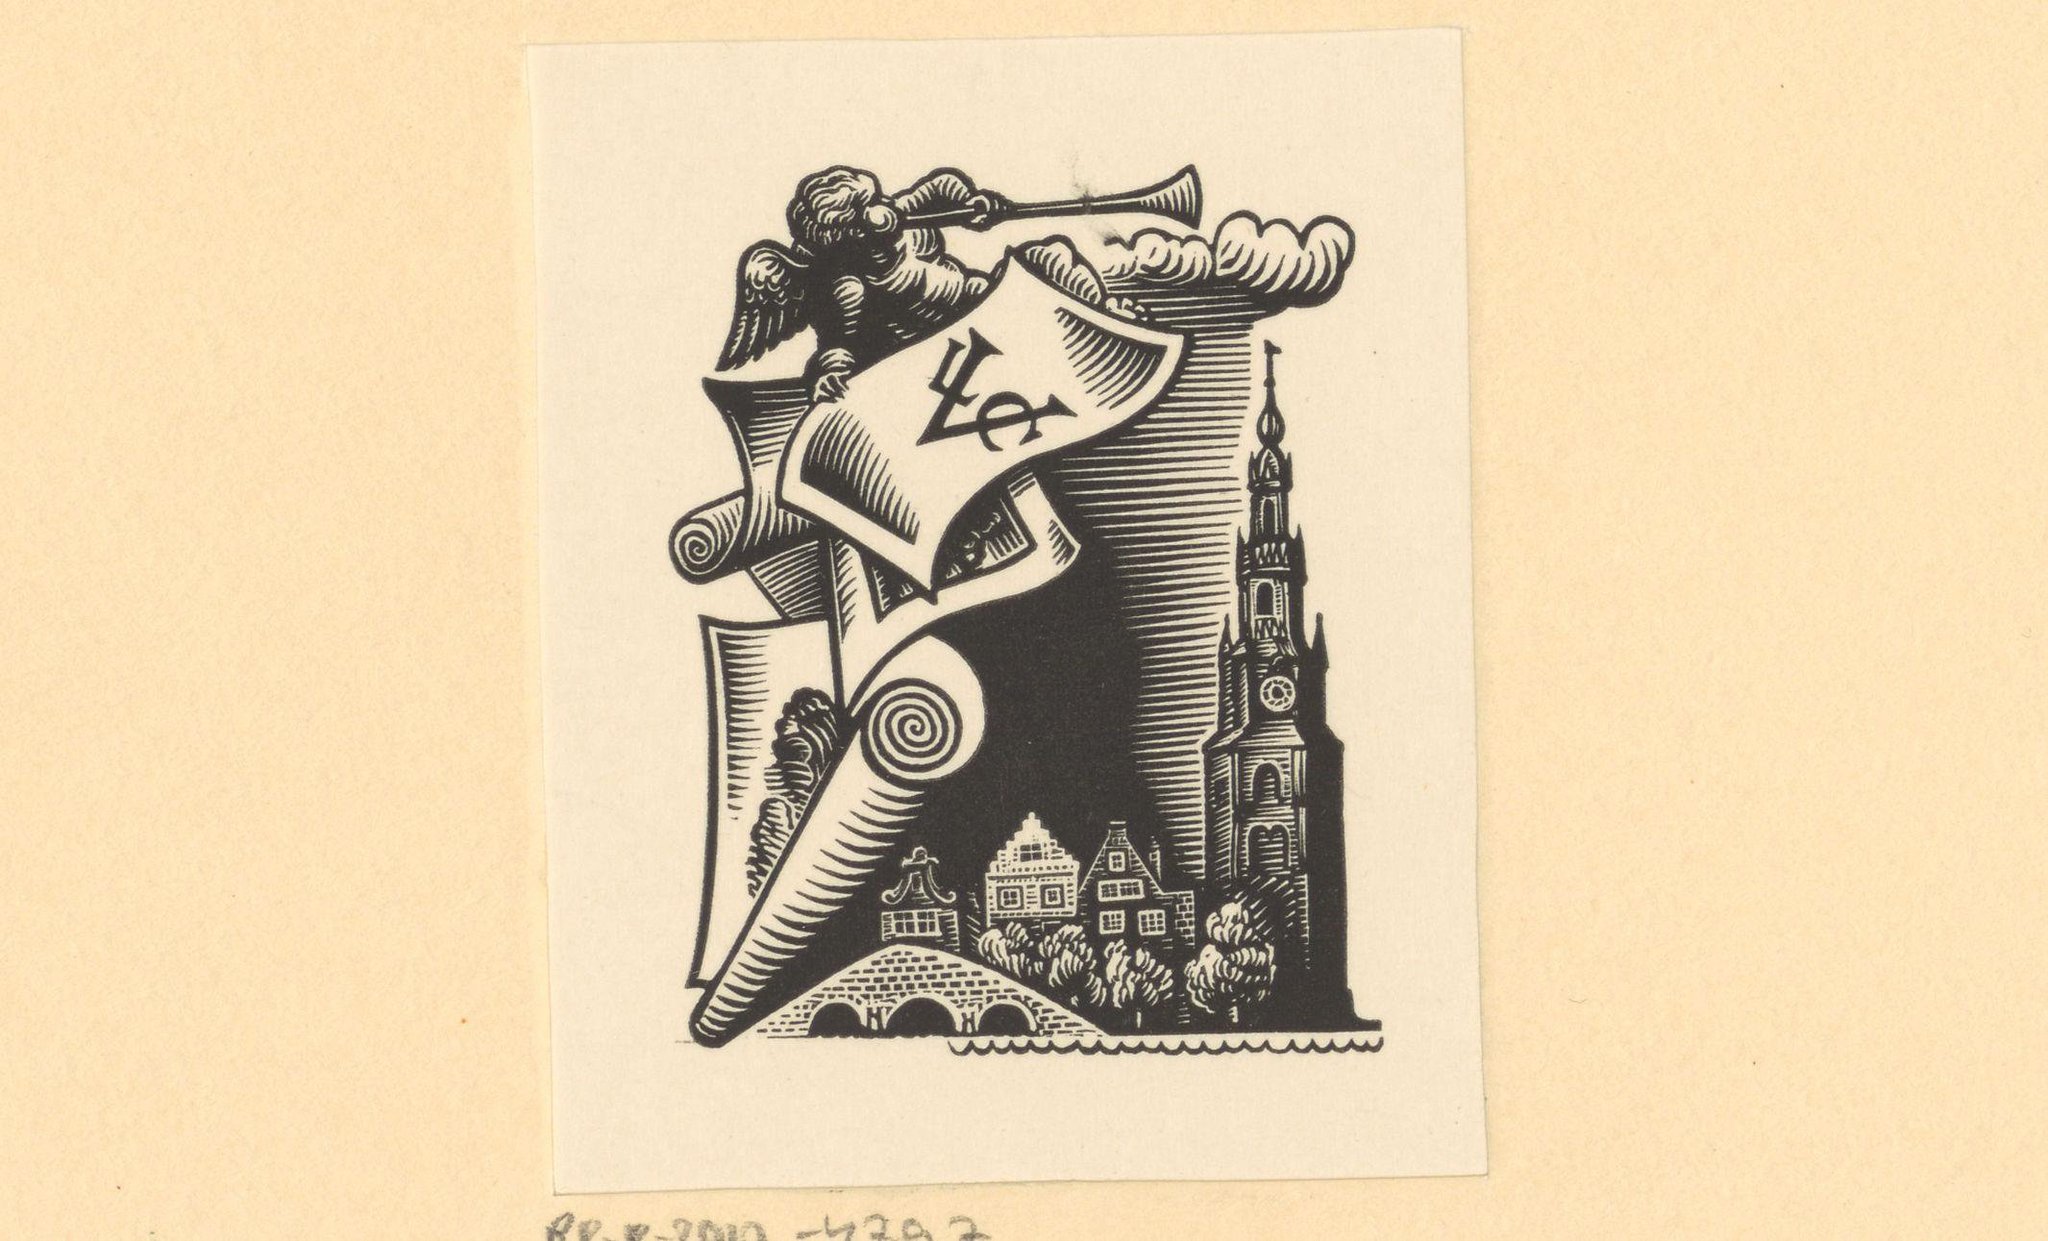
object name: bookplate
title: Ex libris van V.L.C.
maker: valentin le campion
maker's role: print maker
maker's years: 1861-1952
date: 1920-1952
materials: paper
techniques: engraving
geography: paris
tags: print maker, valentin le campion, parts of church exterior and annexes: campanile, cupids: 'amores', 'amoretti', 'putti', prospect of city, town panorama, silhouette of city, printed matter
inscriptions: inscription: ‘Valentin le Campion, hgr. / Tent. Konstfackskolan 1951-167 [Str. 284b]’, inscription: ‘284b / V. le Campion’